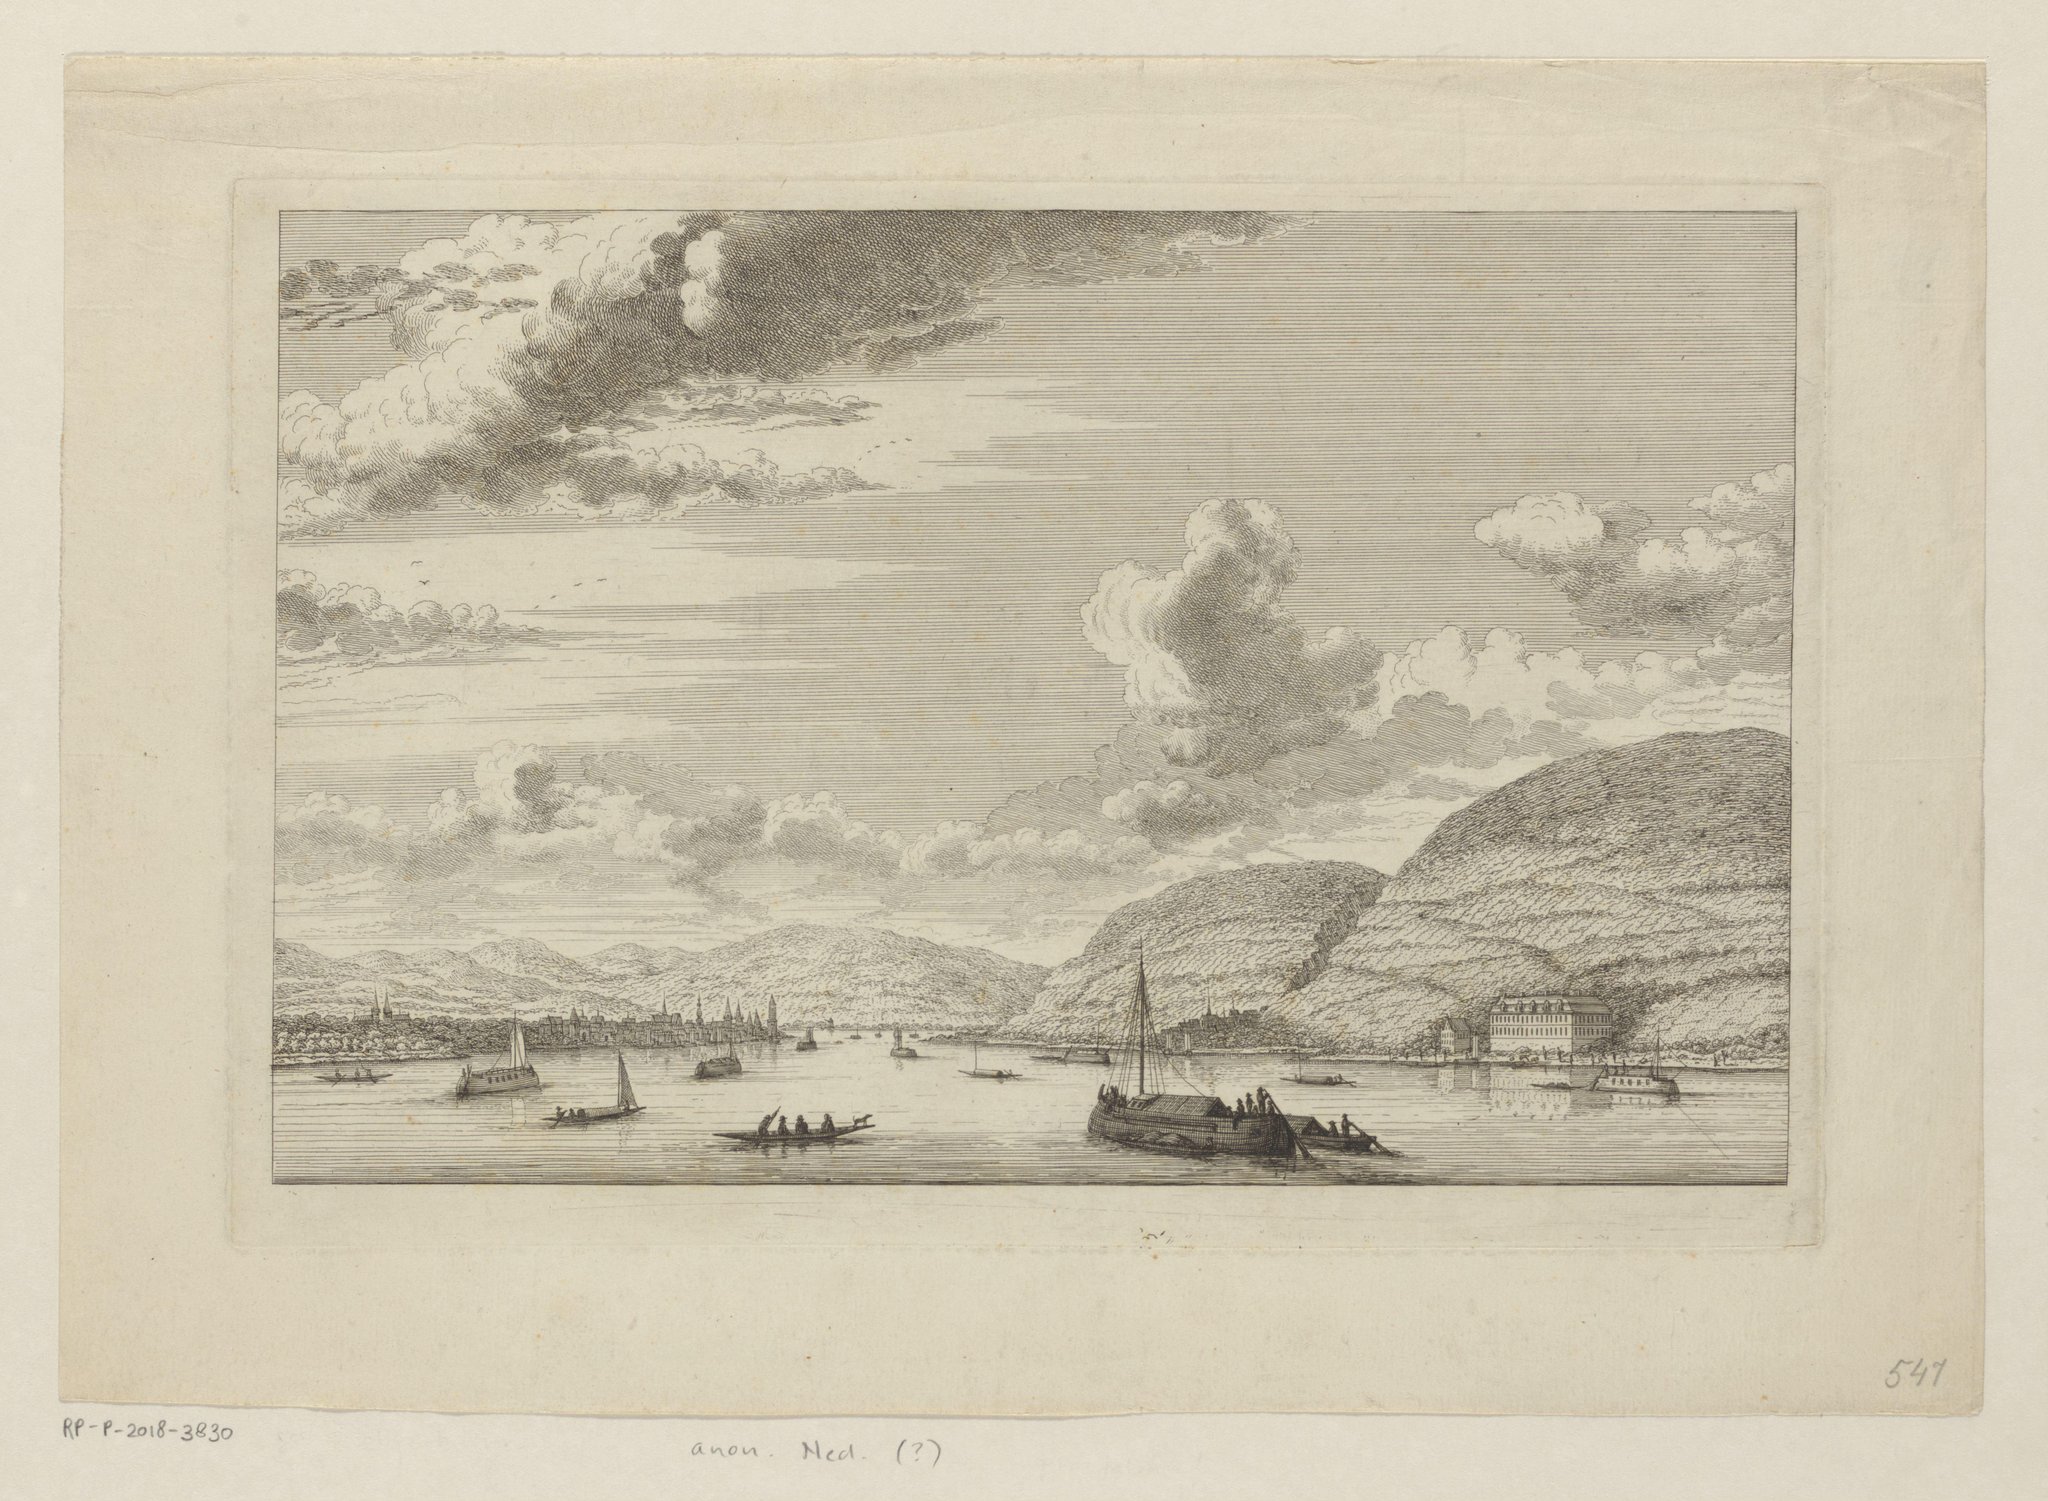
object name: print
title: Gezicht op een meer met boten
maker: Anonymous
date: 1650-1750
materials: paper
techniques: engraving, etching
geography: netherlands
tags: lake, traffic on the water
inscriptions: collector's mark: Lugt 2228